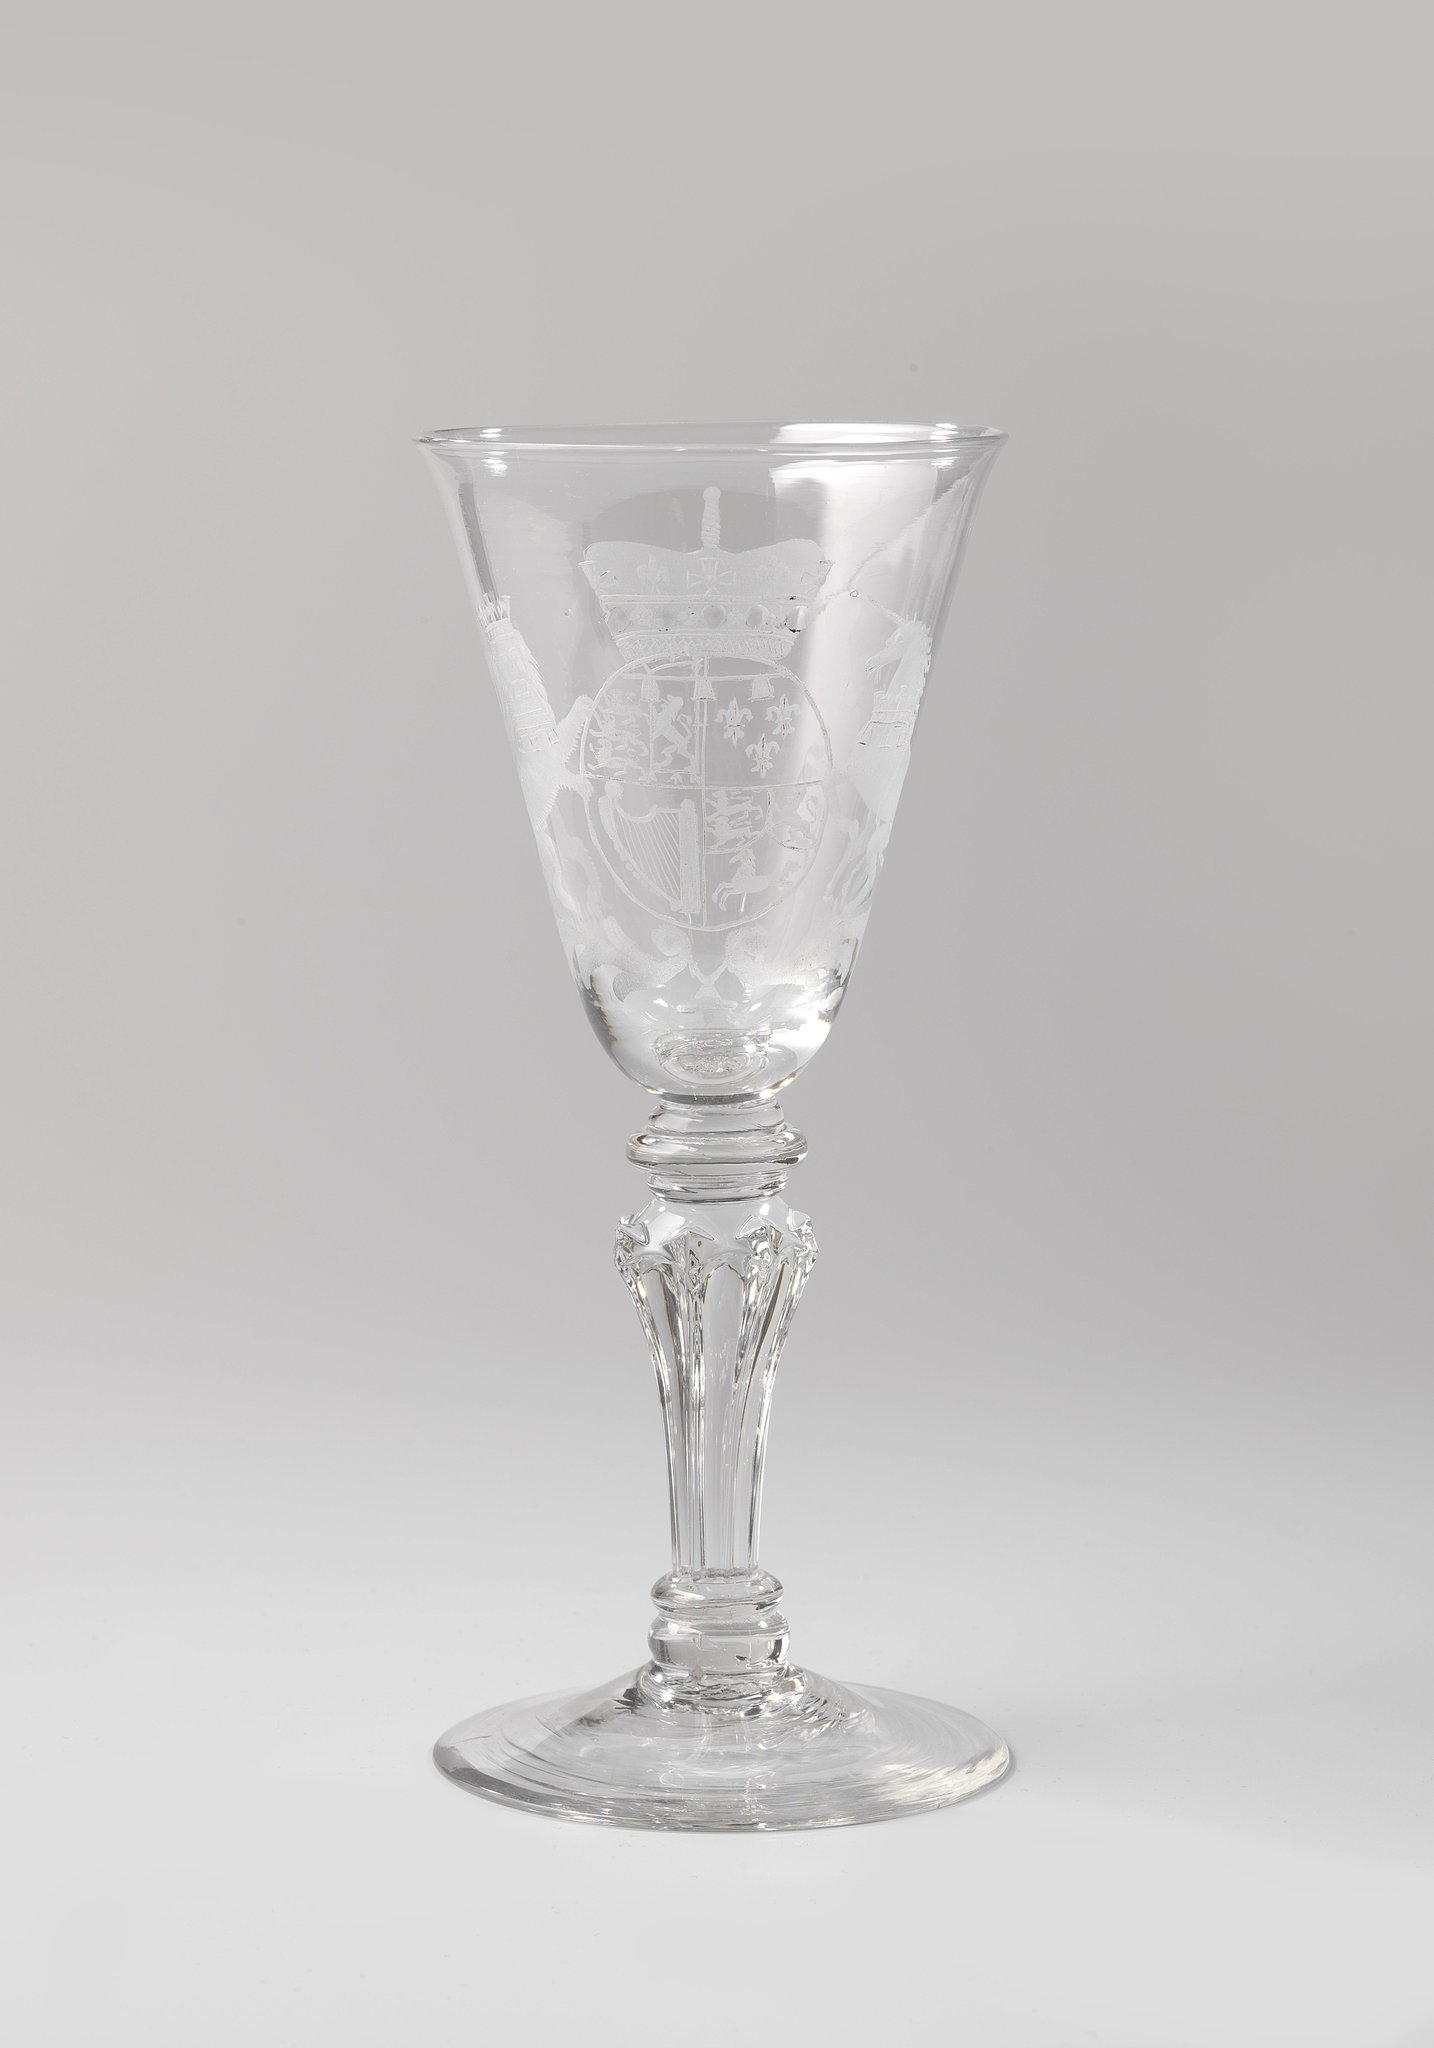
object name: goblet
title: Bokaal met het wapen van Anna van Hannover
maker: Anonymous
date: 1735-1750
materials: glass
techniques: glassblowing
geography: northern netherlands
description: Bokaal van helder, kleurloos glas met conische voet. Zeshoekige in vorm geblazen stam met ringenn en een knop. Op de conische kelk in radgravure het gekroonde wapen van Anna van Hannover (1709-1759).